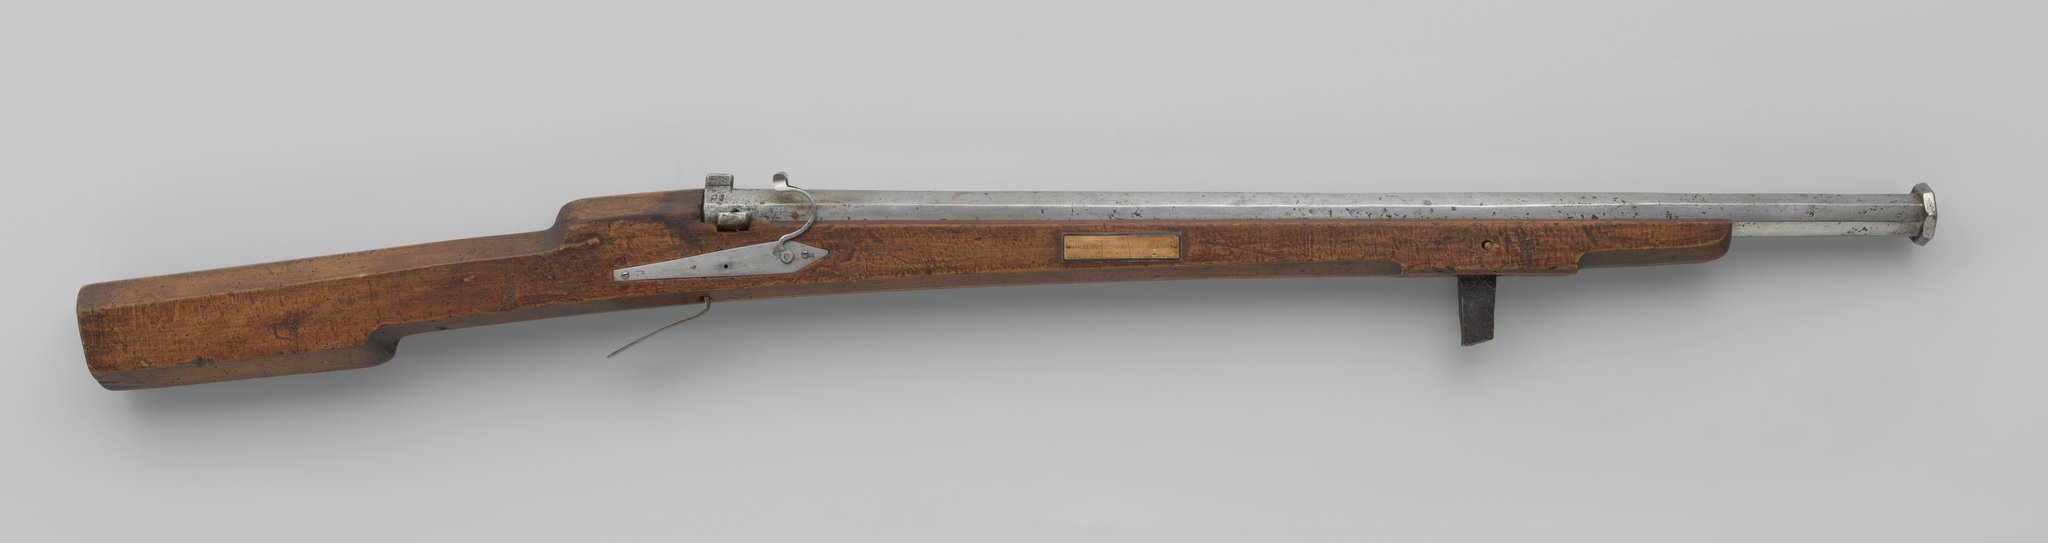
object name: musketoon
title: Klover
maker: Anonymous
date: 1500-1550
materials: iron, wood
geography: netherlands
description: Walbuks (knipbus, vroeger loodbus). Loop achtkantig, gemerkt als NG-KOG-856: 'wapenschild met kruis, waarin 3 kruizen'. Terugverende lonthaan. Lengte van de loop 1,26 m, kaliber 27 mm.